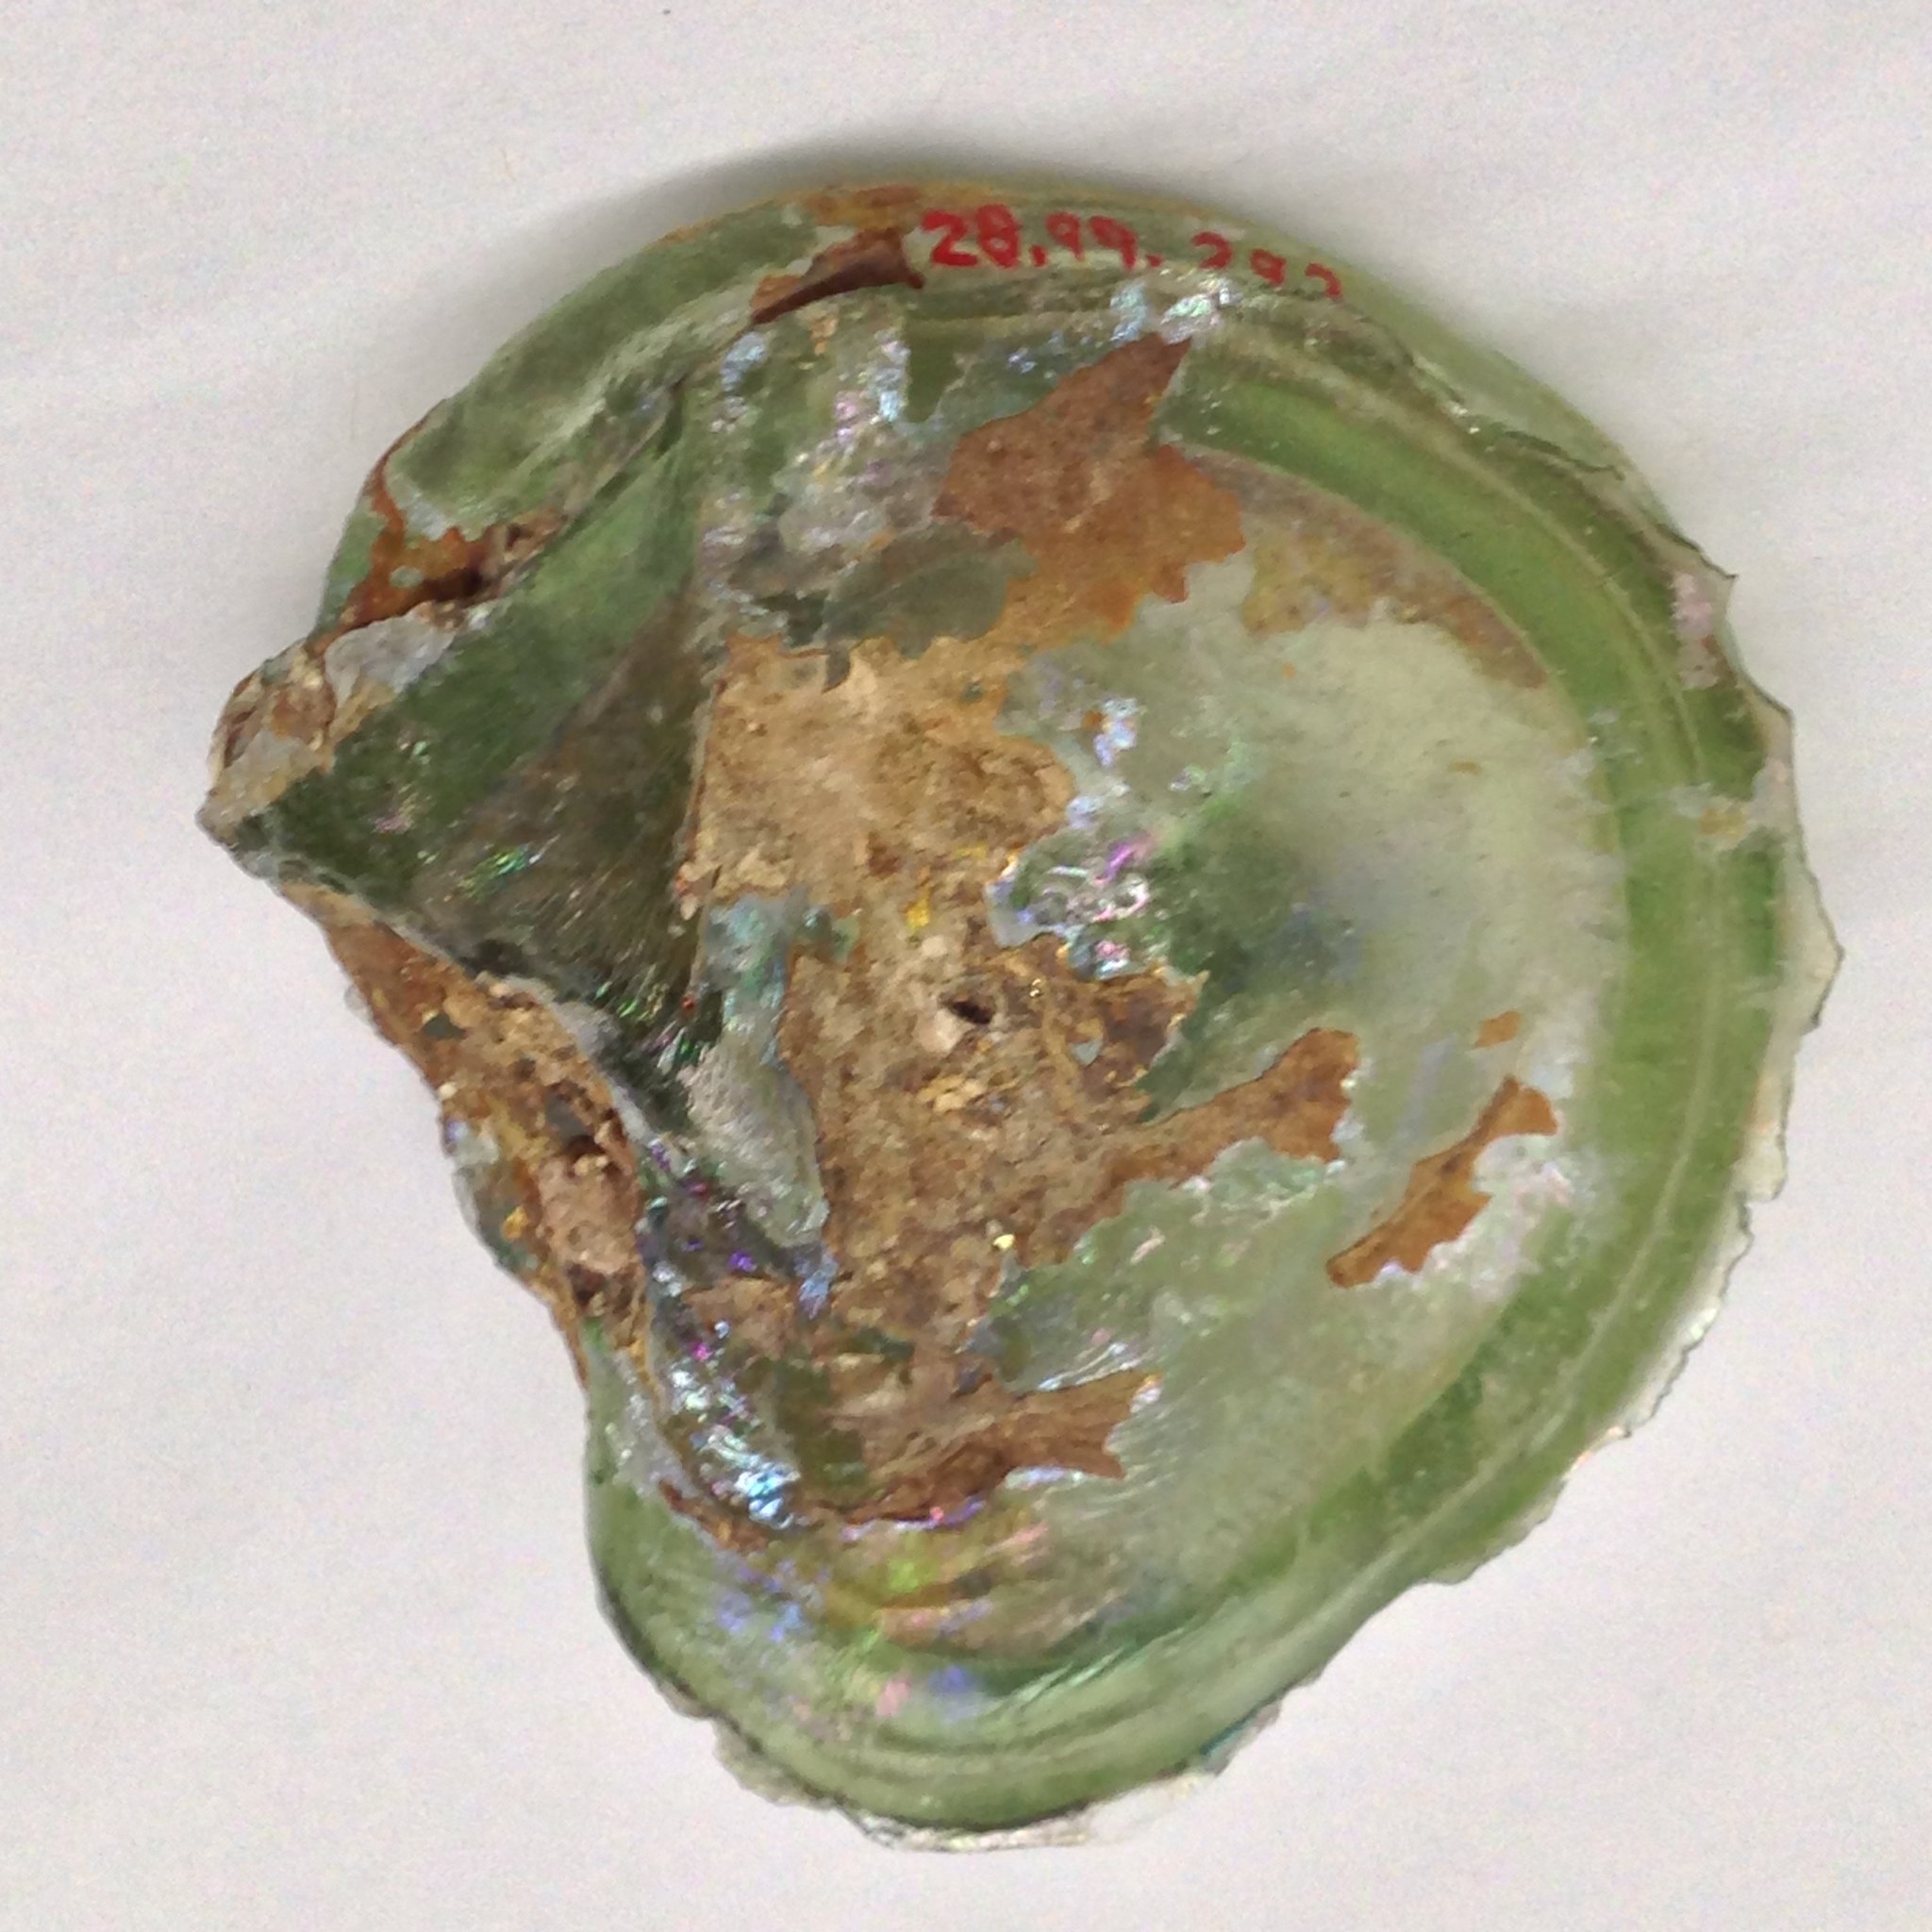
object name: fragment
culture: european or middle eastern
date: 1150-1250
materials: ceramic, glass